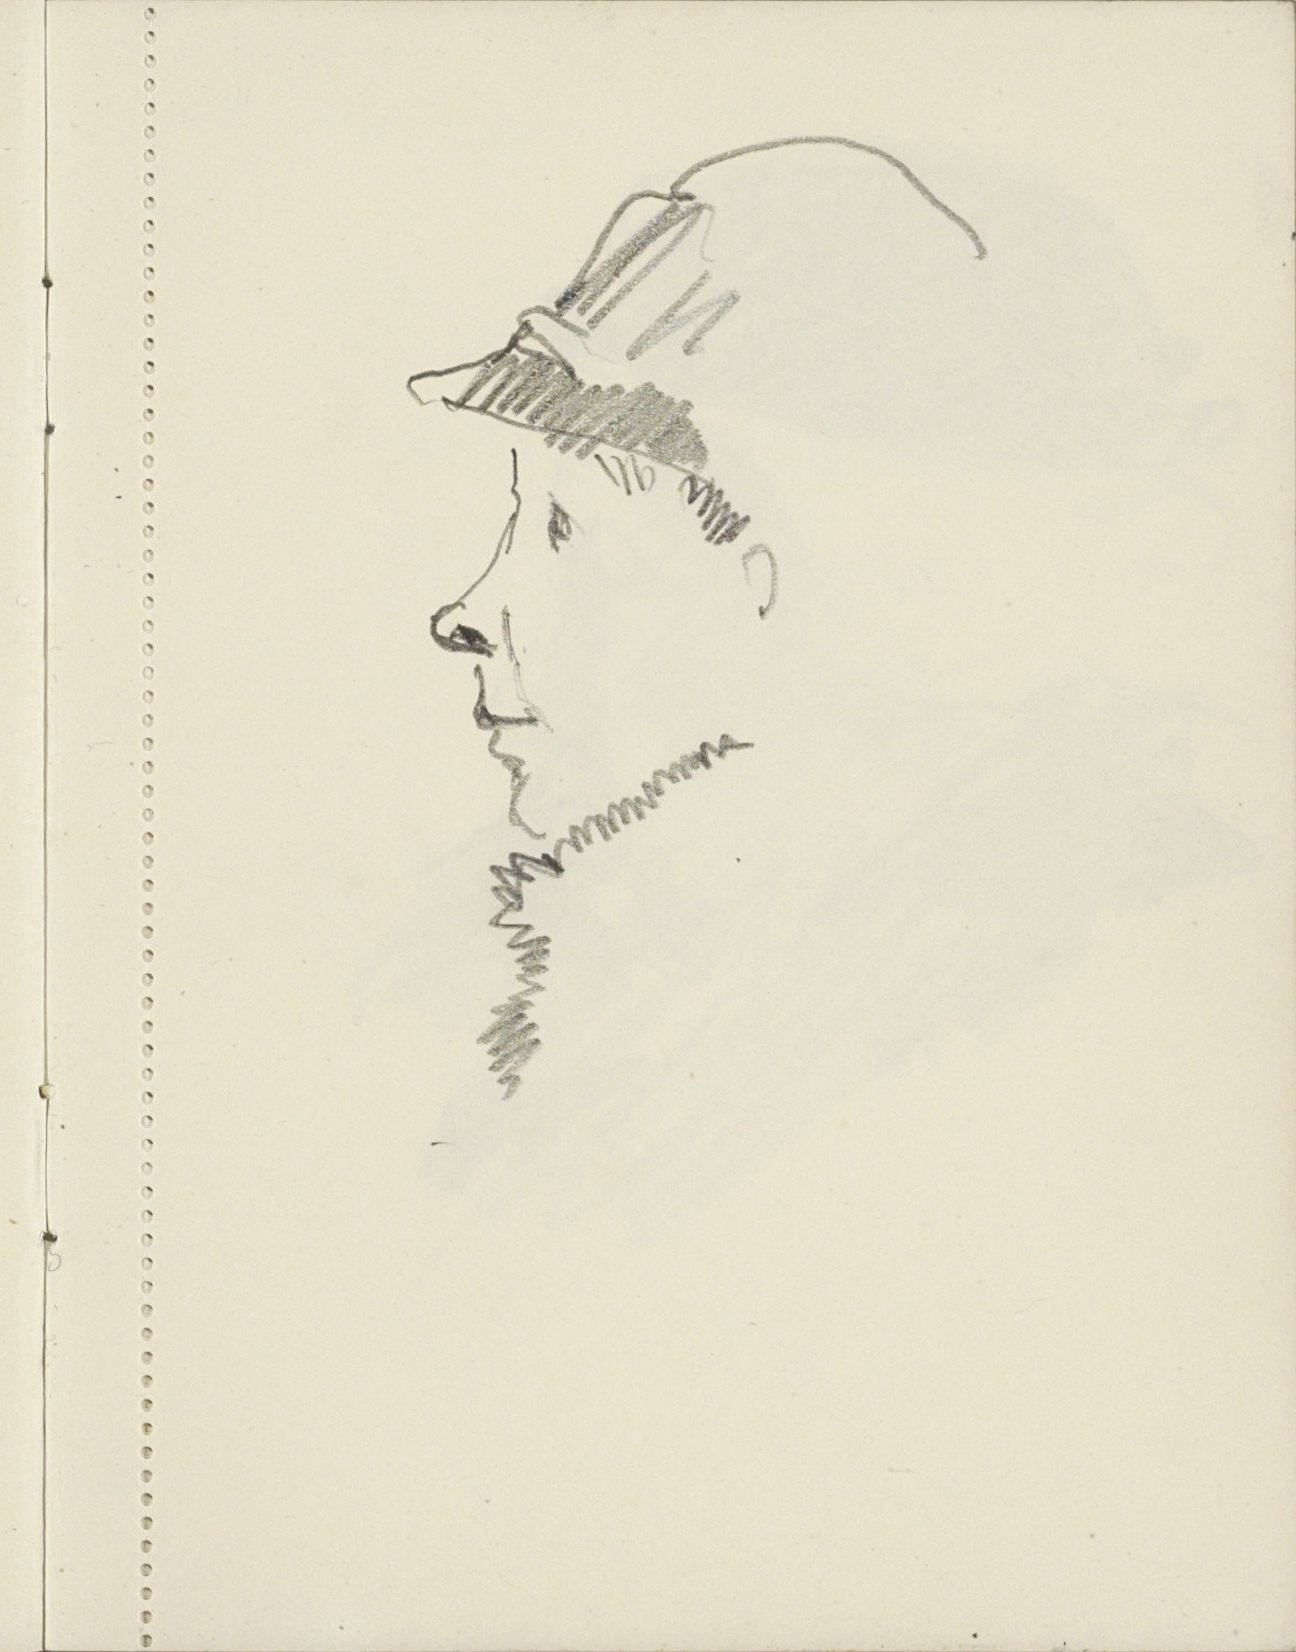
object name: sketchbook leaf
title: Kop van een man met een pet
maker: cornelis vreedenburgh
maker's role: draughtsman, print maker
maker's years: 1880-1946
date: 1890-1946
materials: paper, pencil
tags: head (human) (+ left side visible; left - (l. hand, l. foot, etc.)), head-gear: hat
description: Blad 15 recto uit een schetsboek met 71 bladen.